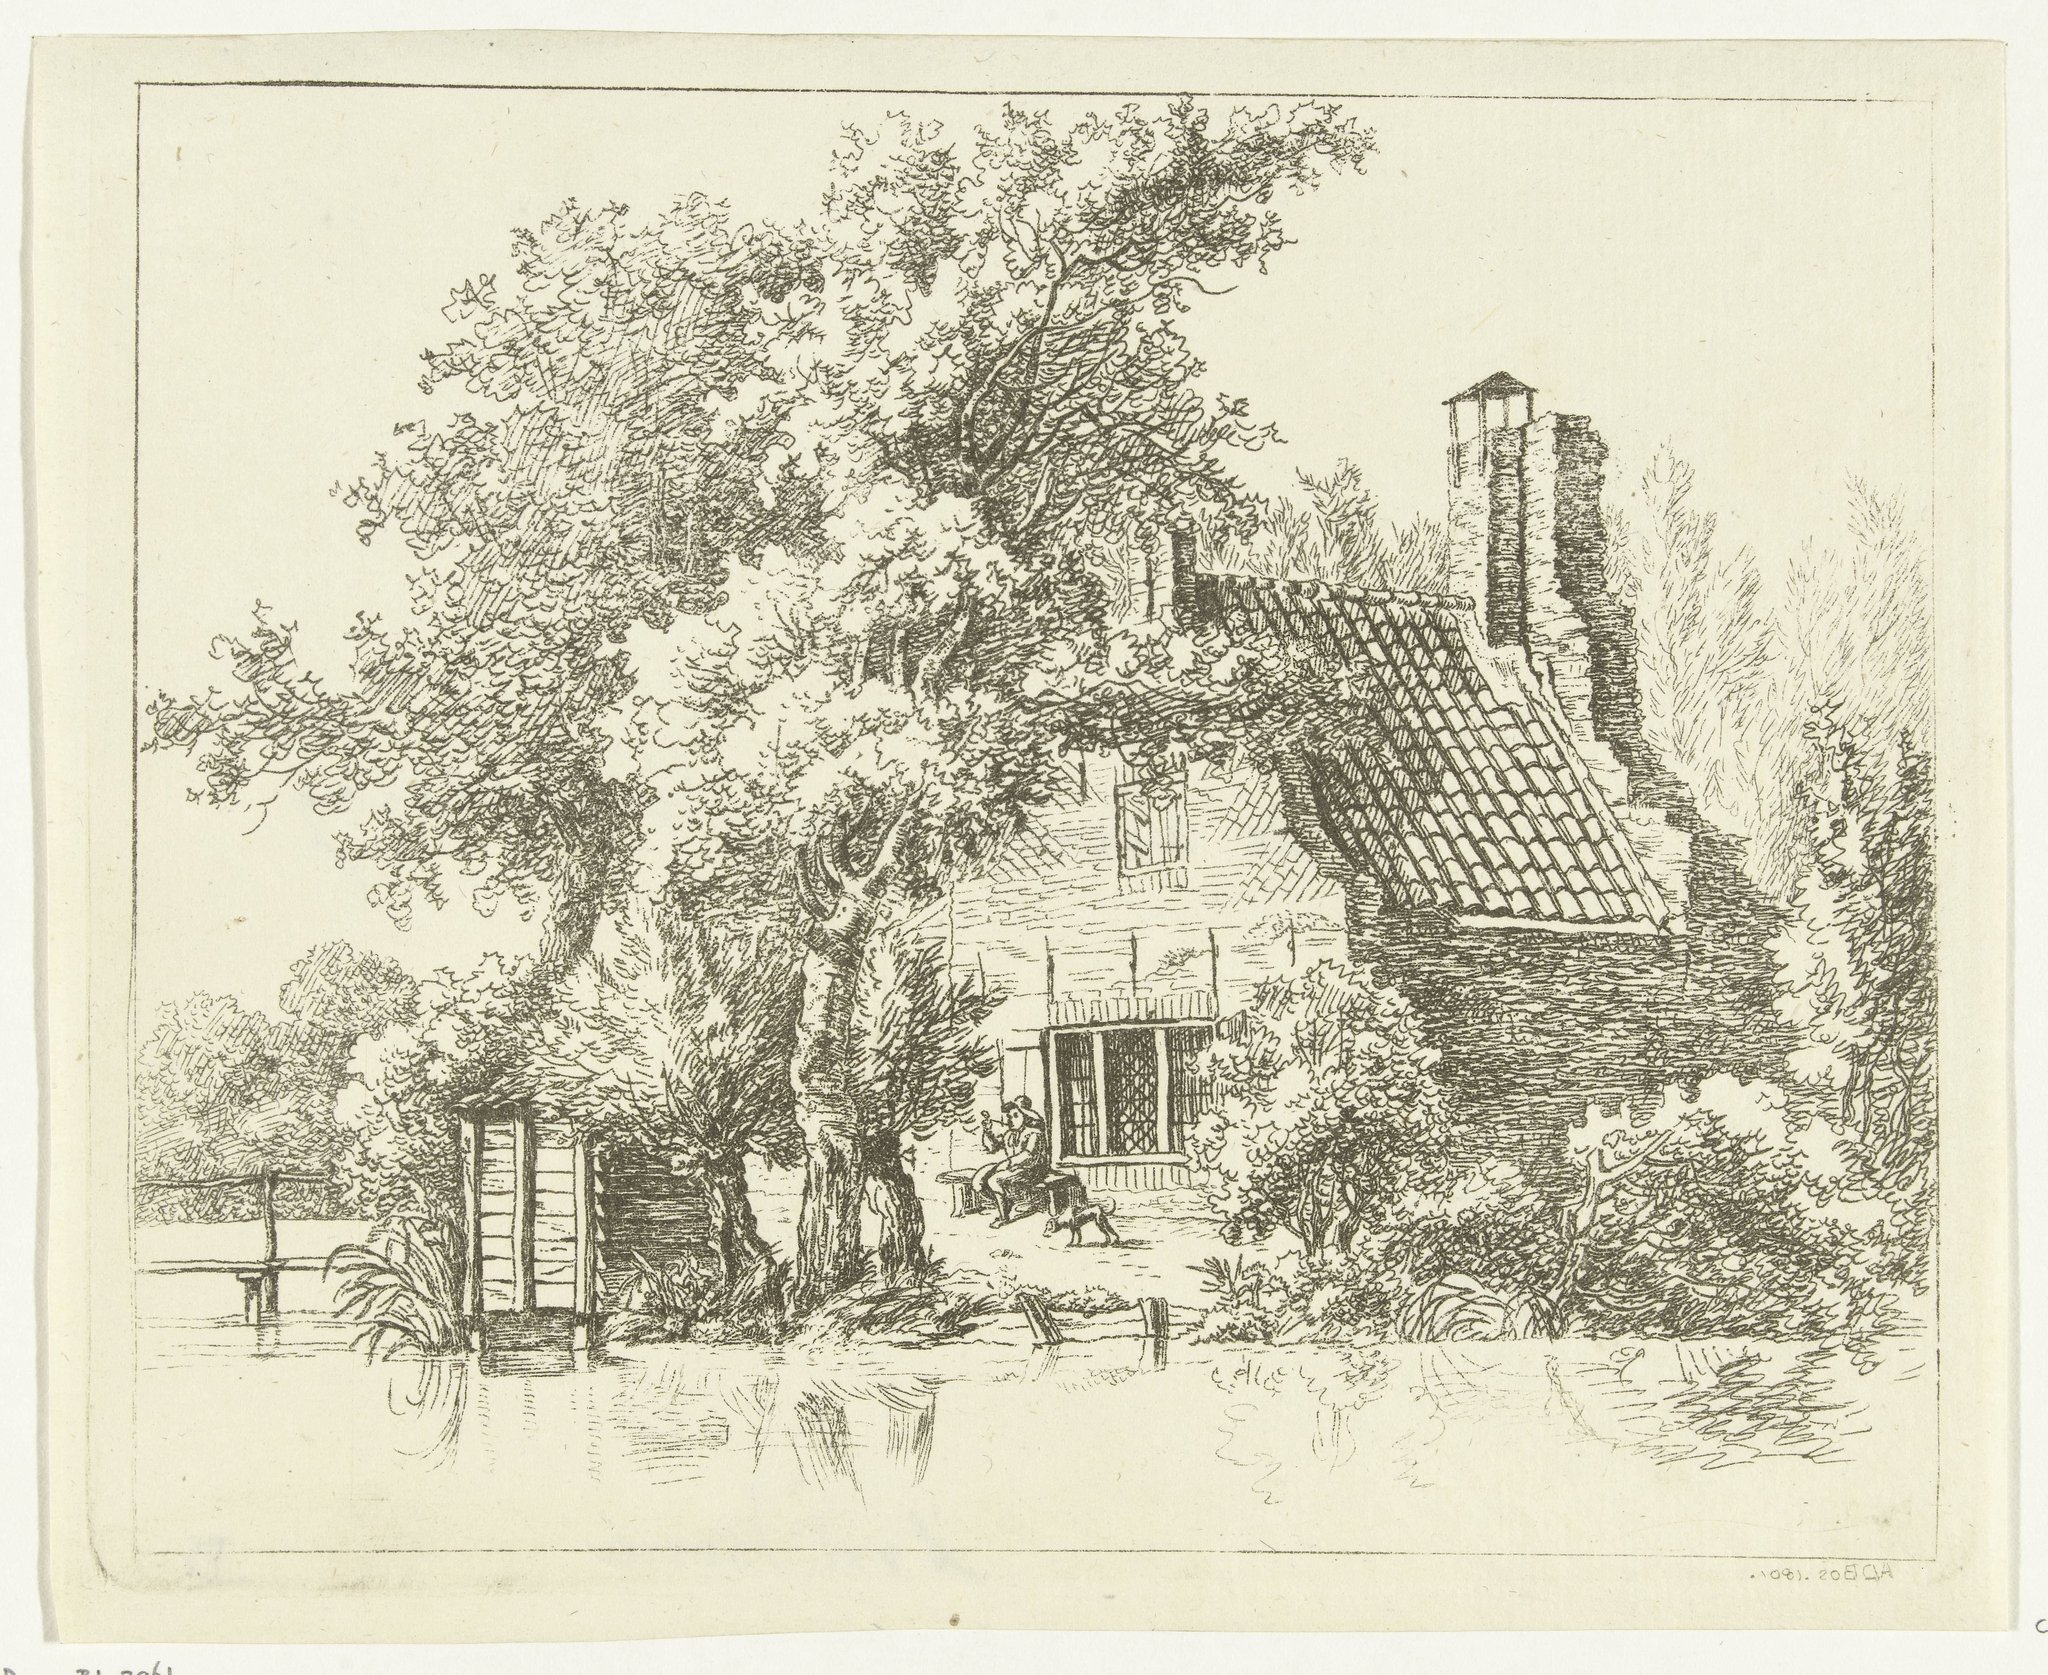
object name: print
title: Rokende man op een bankje voor de ruïne van het Huis Snaatburg te Maarssen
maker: anthonie van den bos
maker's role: draughtsman, print maker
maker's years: 1763-1838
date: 1801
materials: paper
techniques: printmaking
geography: netherlands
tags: ruin of a dwelling, house, castle, etc.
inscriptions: collector's mark: Lugt 2228